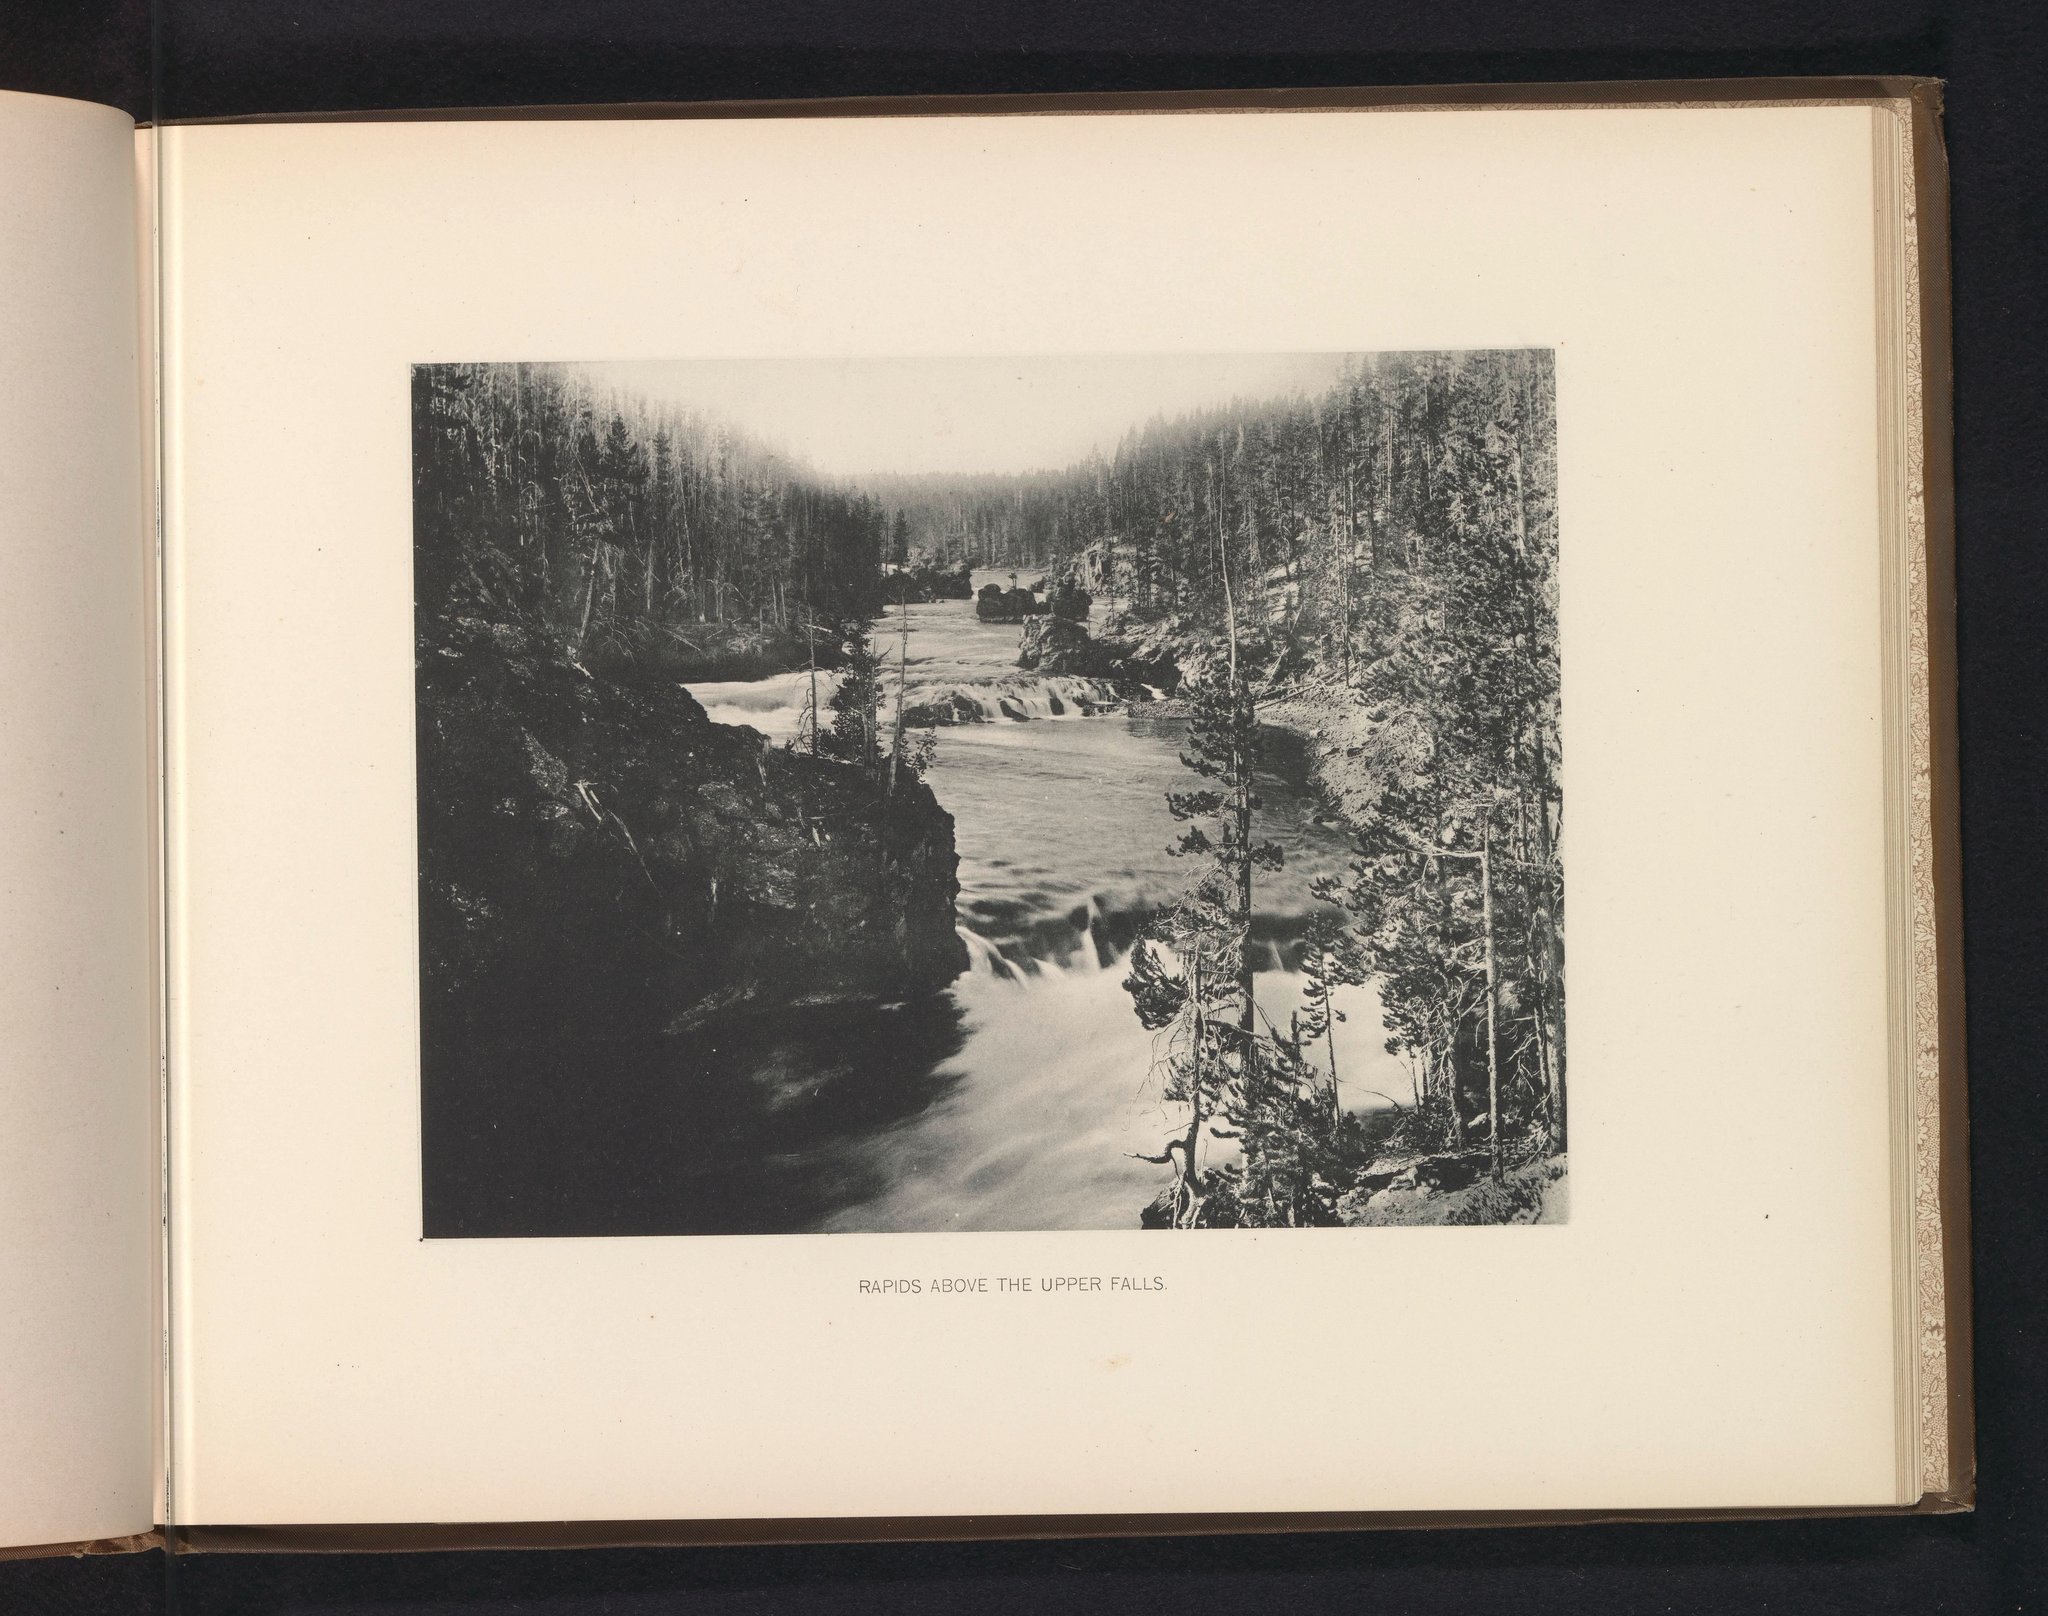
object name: photomechanical print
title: Rapids above the Upper Falls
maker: frank jay haynes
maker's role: fotograaf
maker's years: 1853-1921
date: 1886-1891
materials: paper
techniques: photograph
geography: yellowstone national park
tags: rapids, river